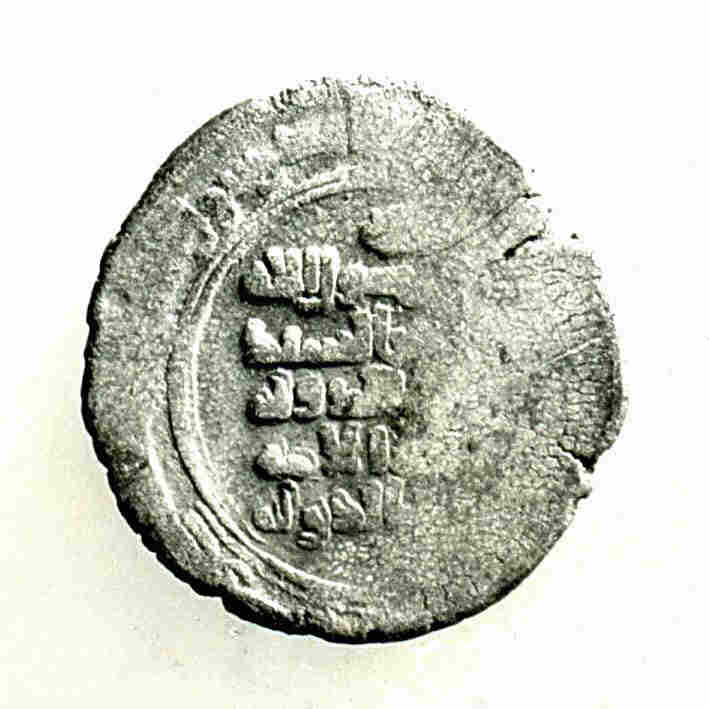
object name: coin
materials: silver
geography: al-muhammadiyya